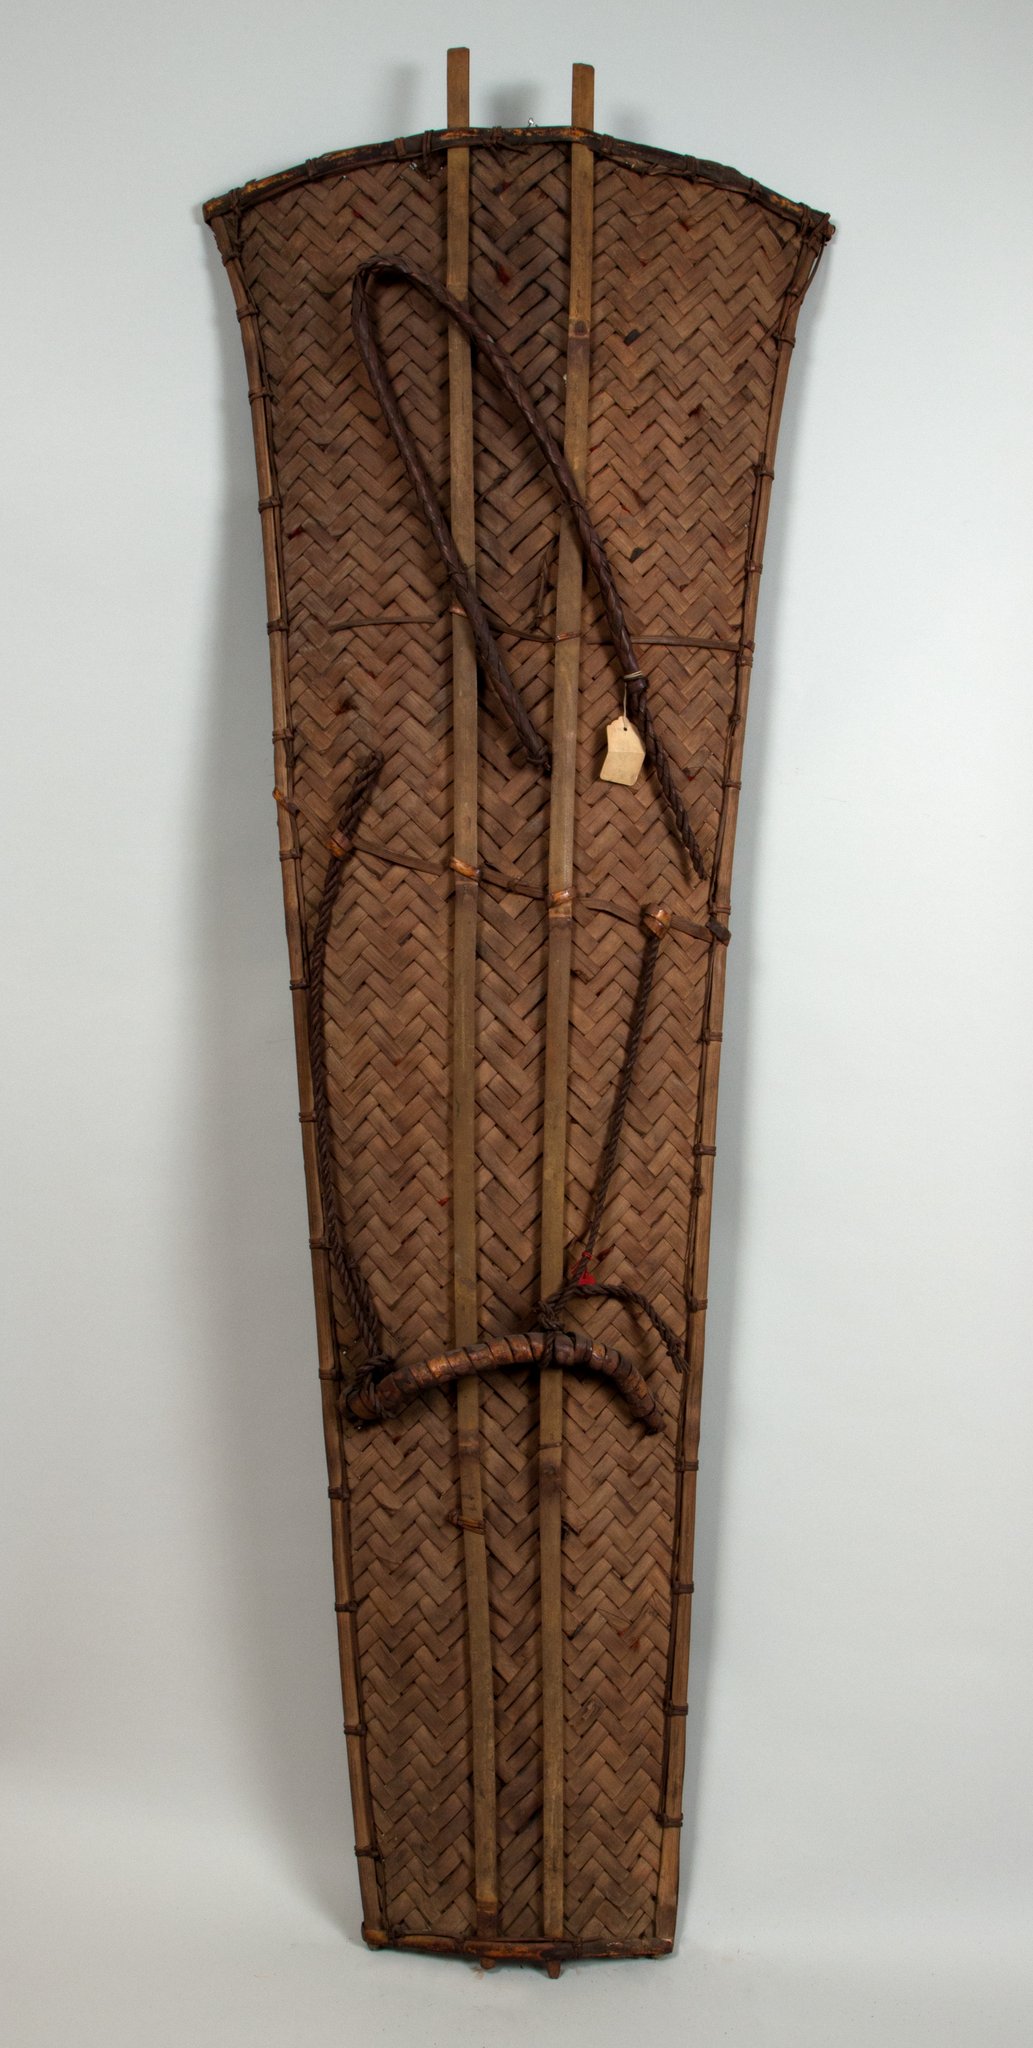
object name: shield dhàl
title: Shield (Dhàl)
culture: indian, assam or naga hills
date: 1801-1900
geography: india